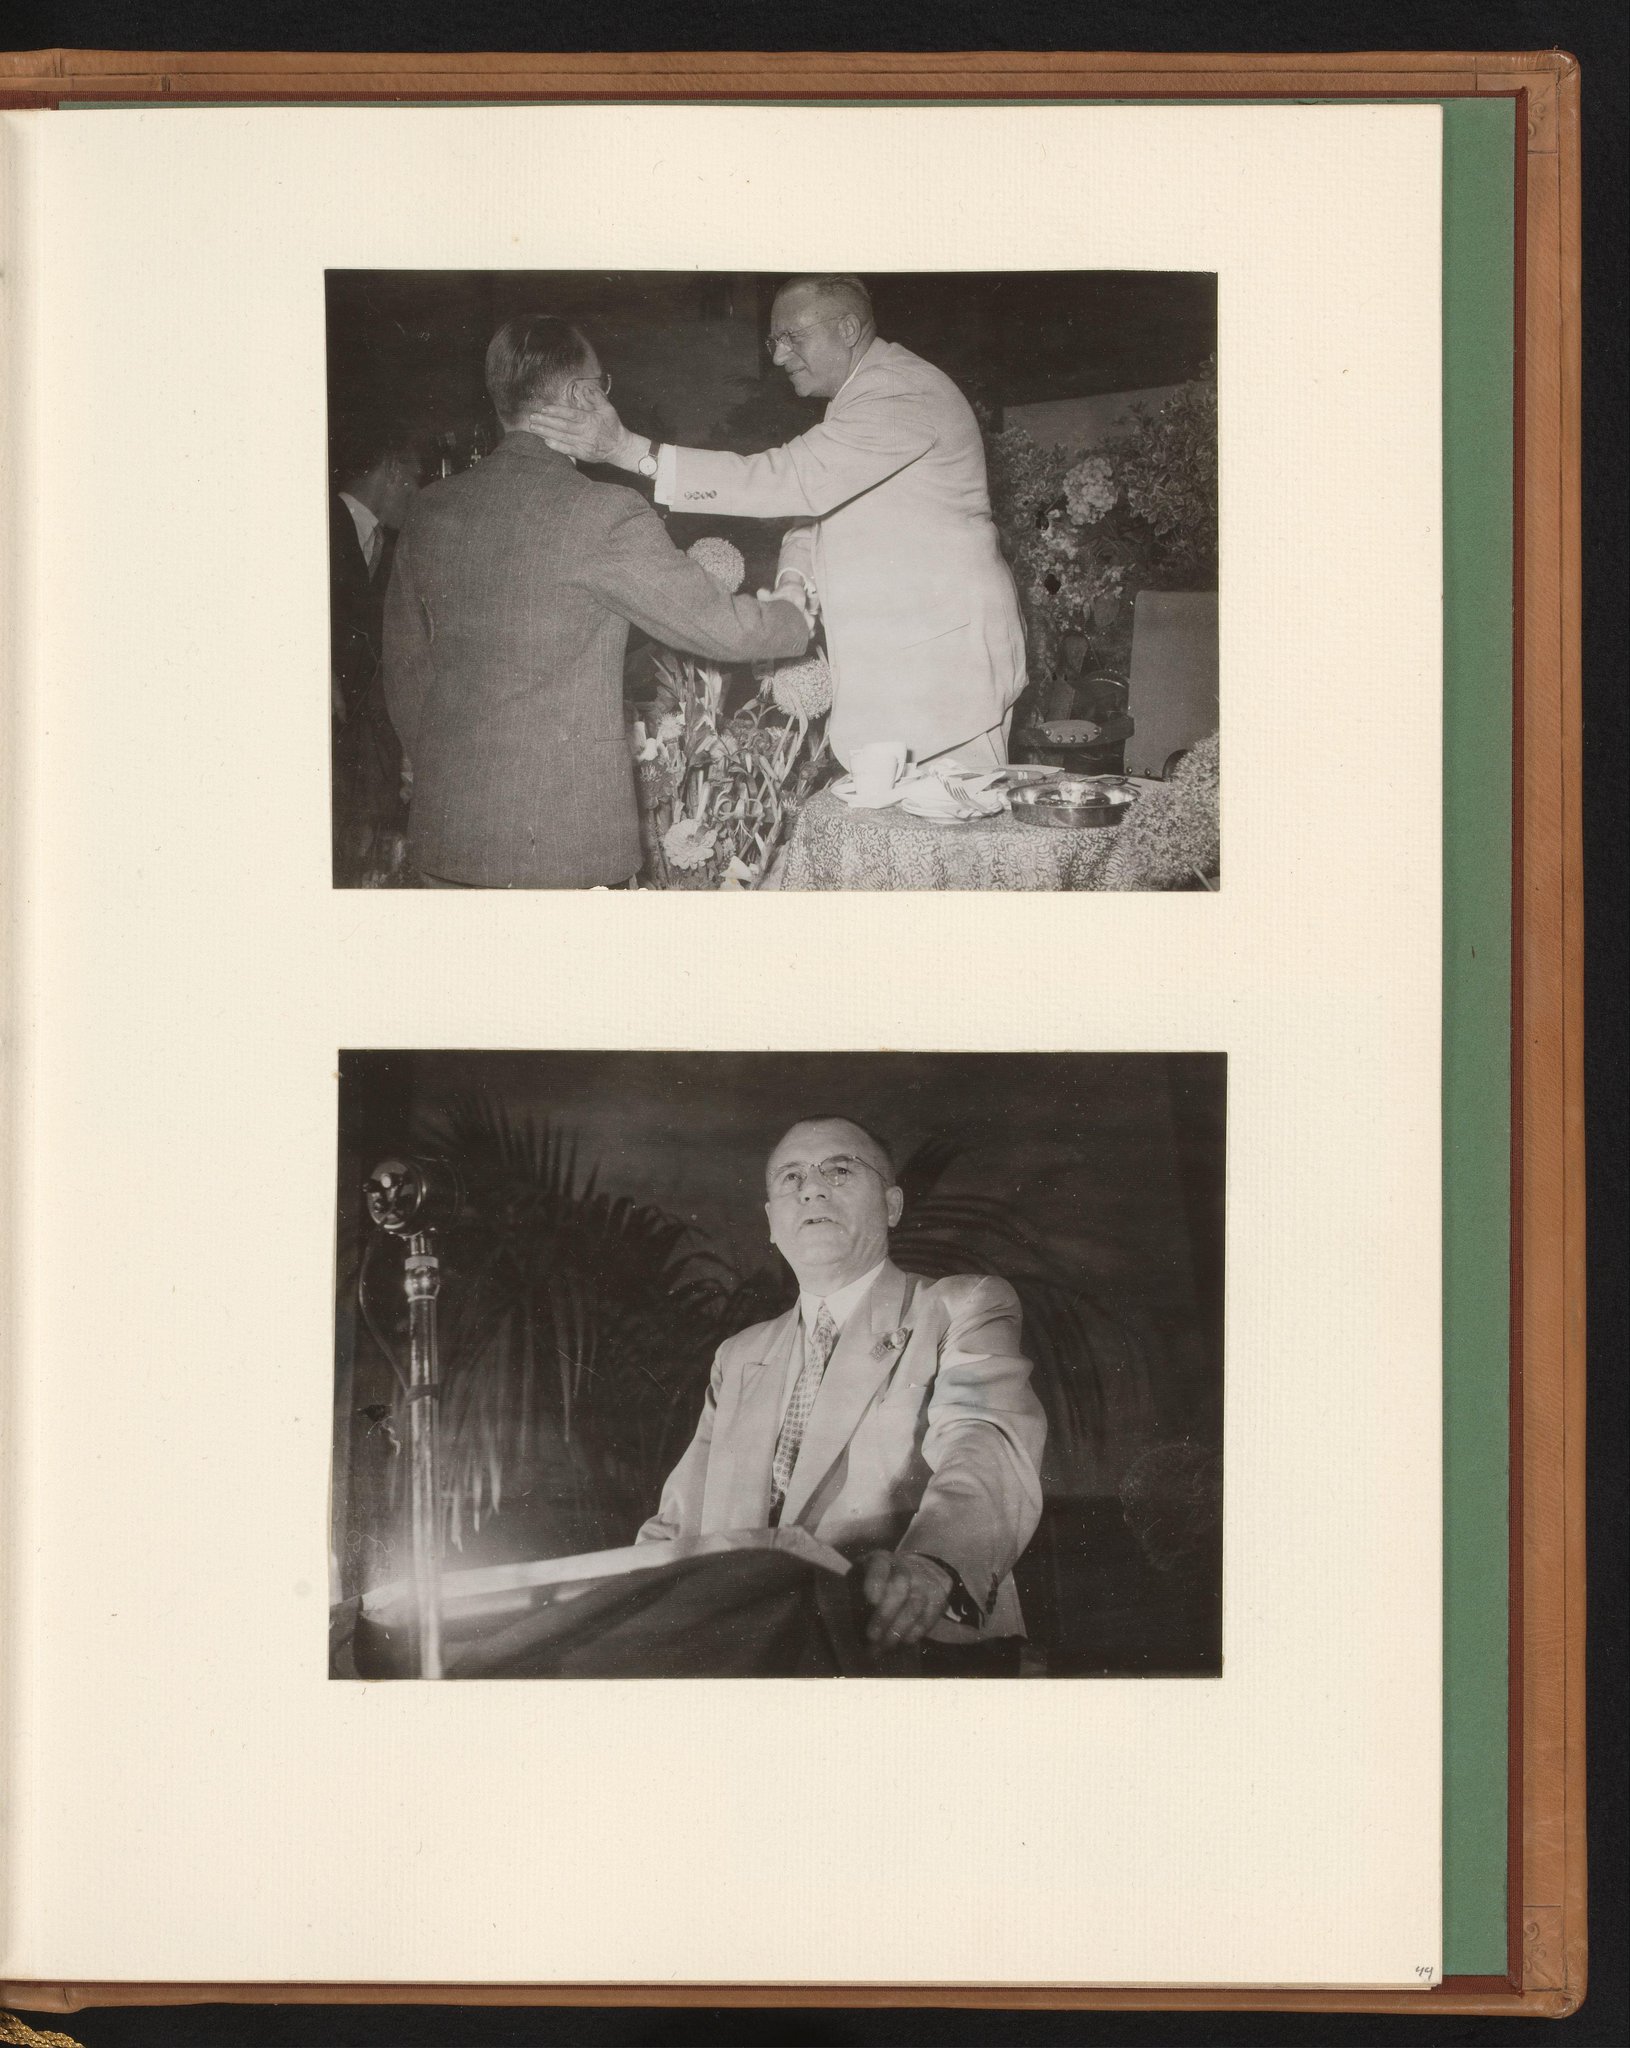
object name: album leaf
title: Afscheid van Kupers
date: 1949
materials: paper, photographic support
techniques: gelatin silver print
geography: amsterdam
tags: shaking hands, 'dextrarum junctio', modern professional organization, trade union, reception, cocktail party, amsterdam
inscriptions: company name: ‘Fotodienst Het Vrije Volk / Hekelveld 15, Amsterdam’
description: Blad met twee foto's waarin Kupers handen schudt (boven) en een toespraak houdt (onder). Onderdeel van het fotoalbum ter gelegenheid van het afscheid van Evert Kupers als voorzitter van de NVV op 14 juli 1949 in Amsterdam.